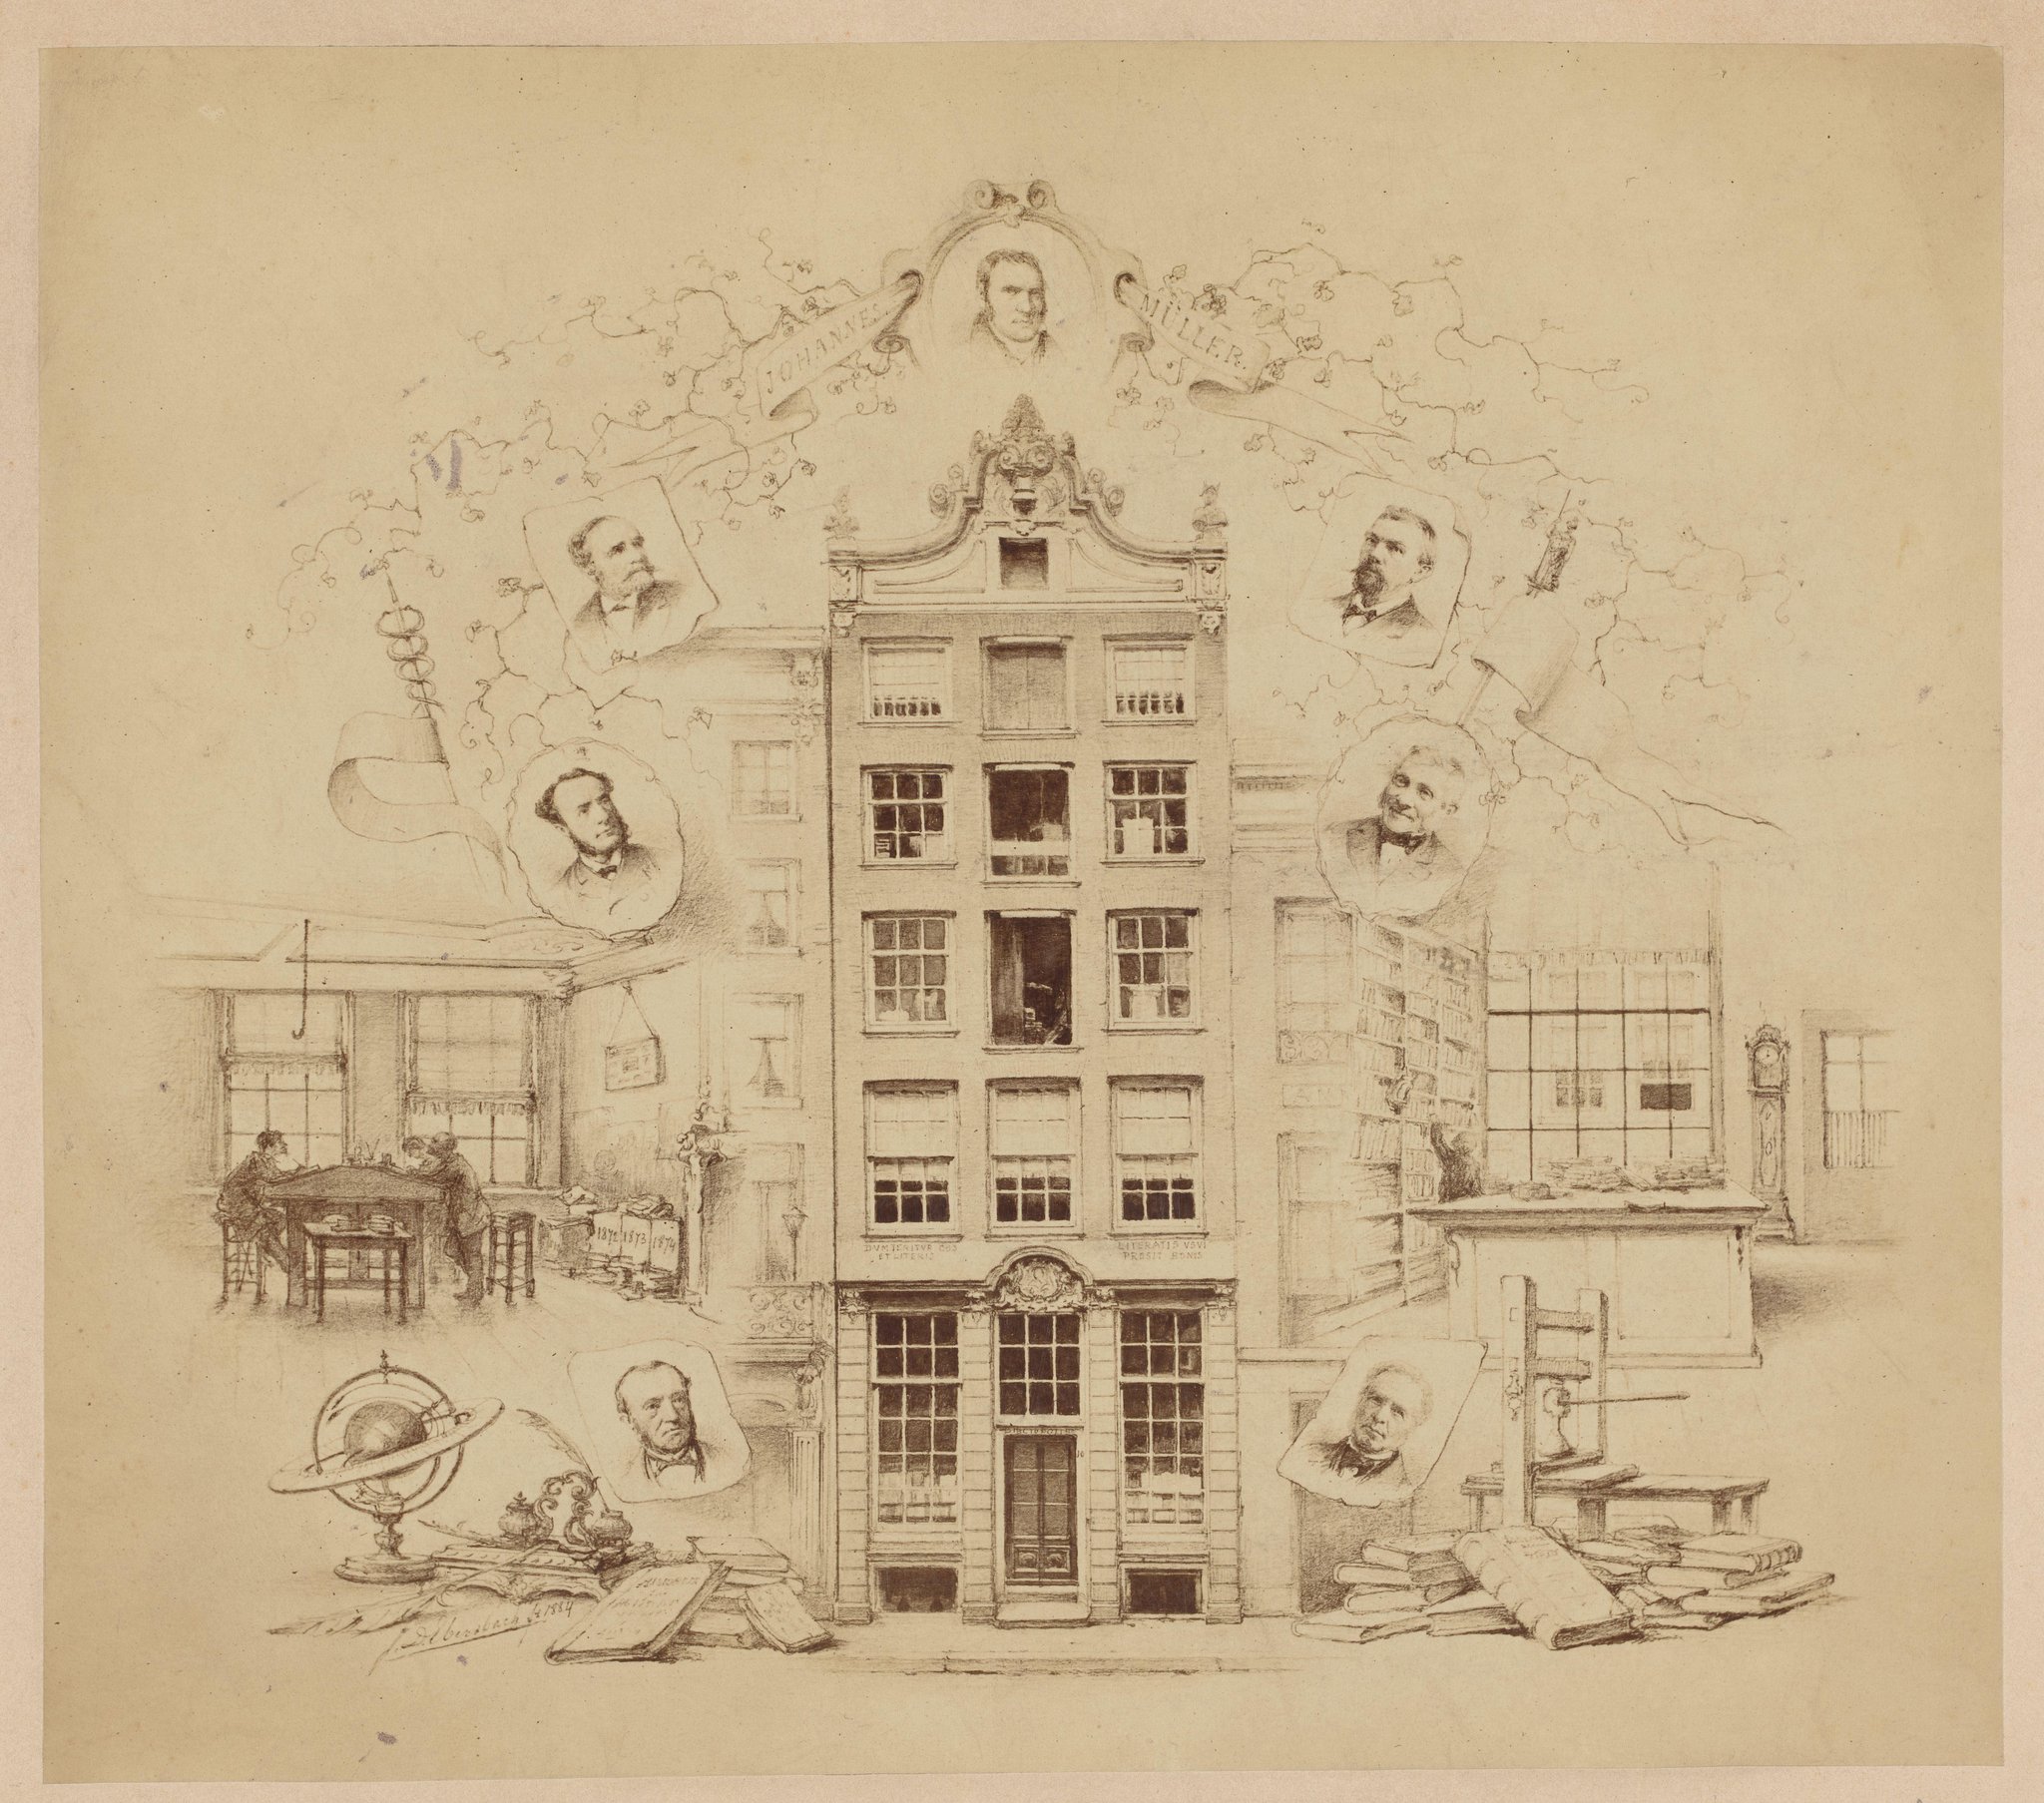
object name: reproduction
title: Fotoreproductie van een tekening van het Bibliopolium van Johannes Müller aan de Kalverstraat te Amsterdam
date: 1884-1900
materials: cardboard, photographic support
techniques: albumen print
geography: amsterdam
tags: interior of the house, façade (of house or building)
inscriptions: number: ‘'21.101’, collector's mark: Lugt 2233, annotation: ‘Huis van Johannes Müller’, inscription: ‘Alexandre & Co./ Photographie Belge/ 182. Kalverstraat, Amsterdam’